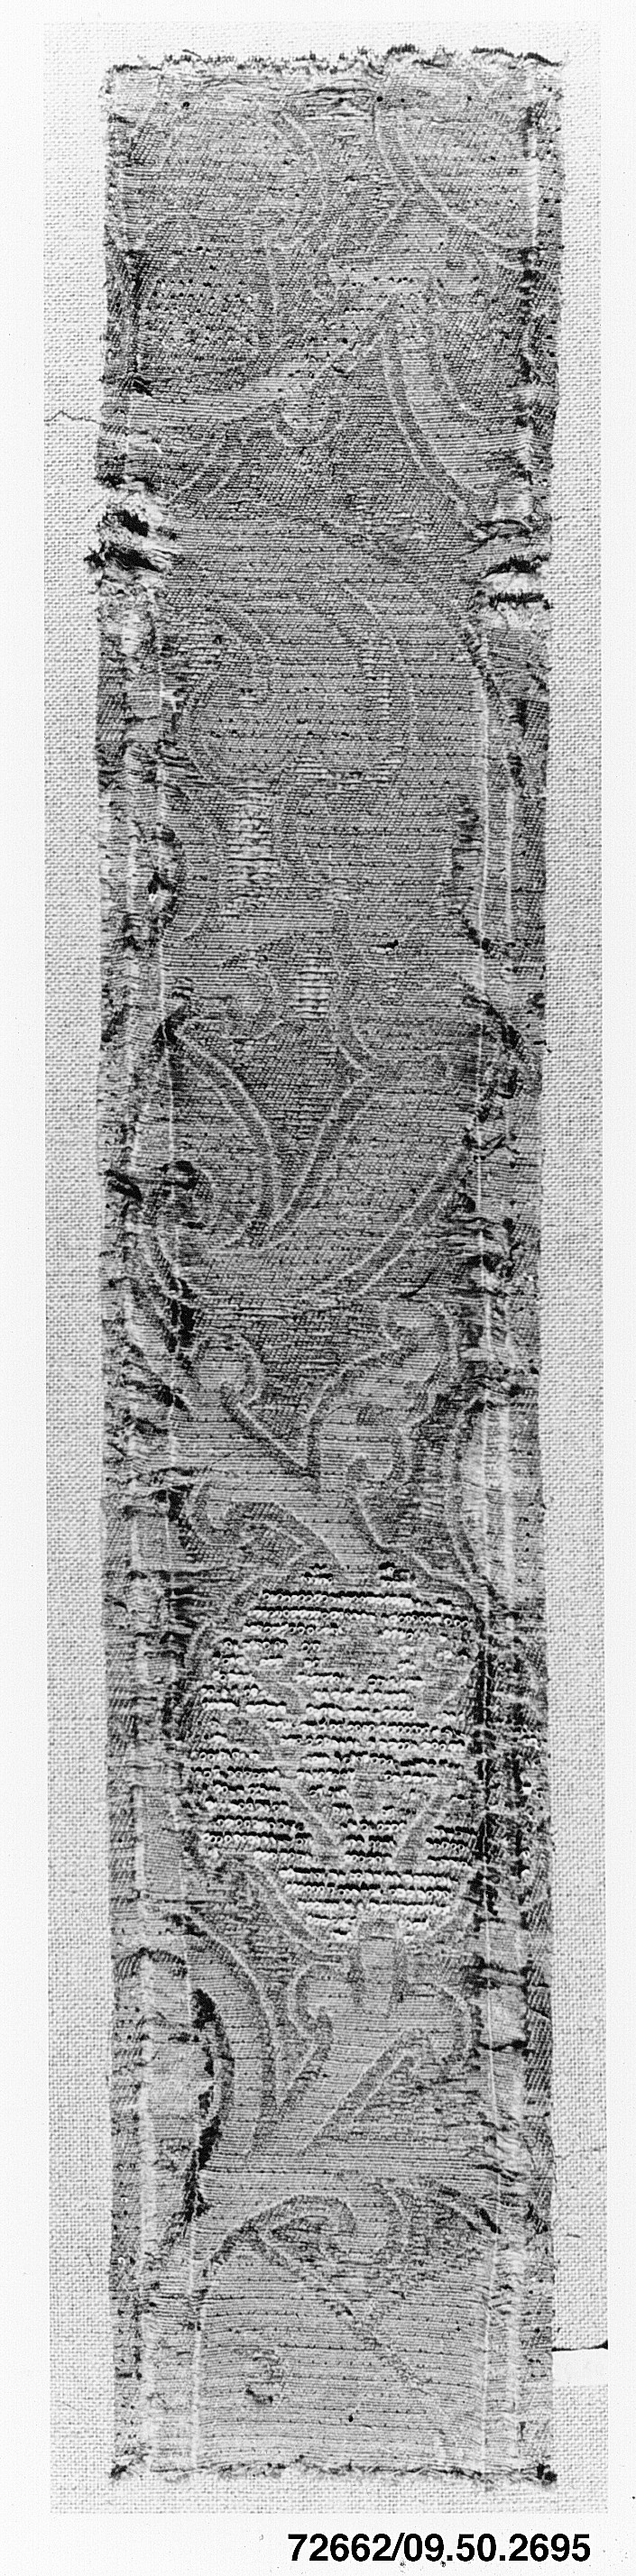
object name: piece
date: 1501-1600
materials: hemp, metal thread, silk